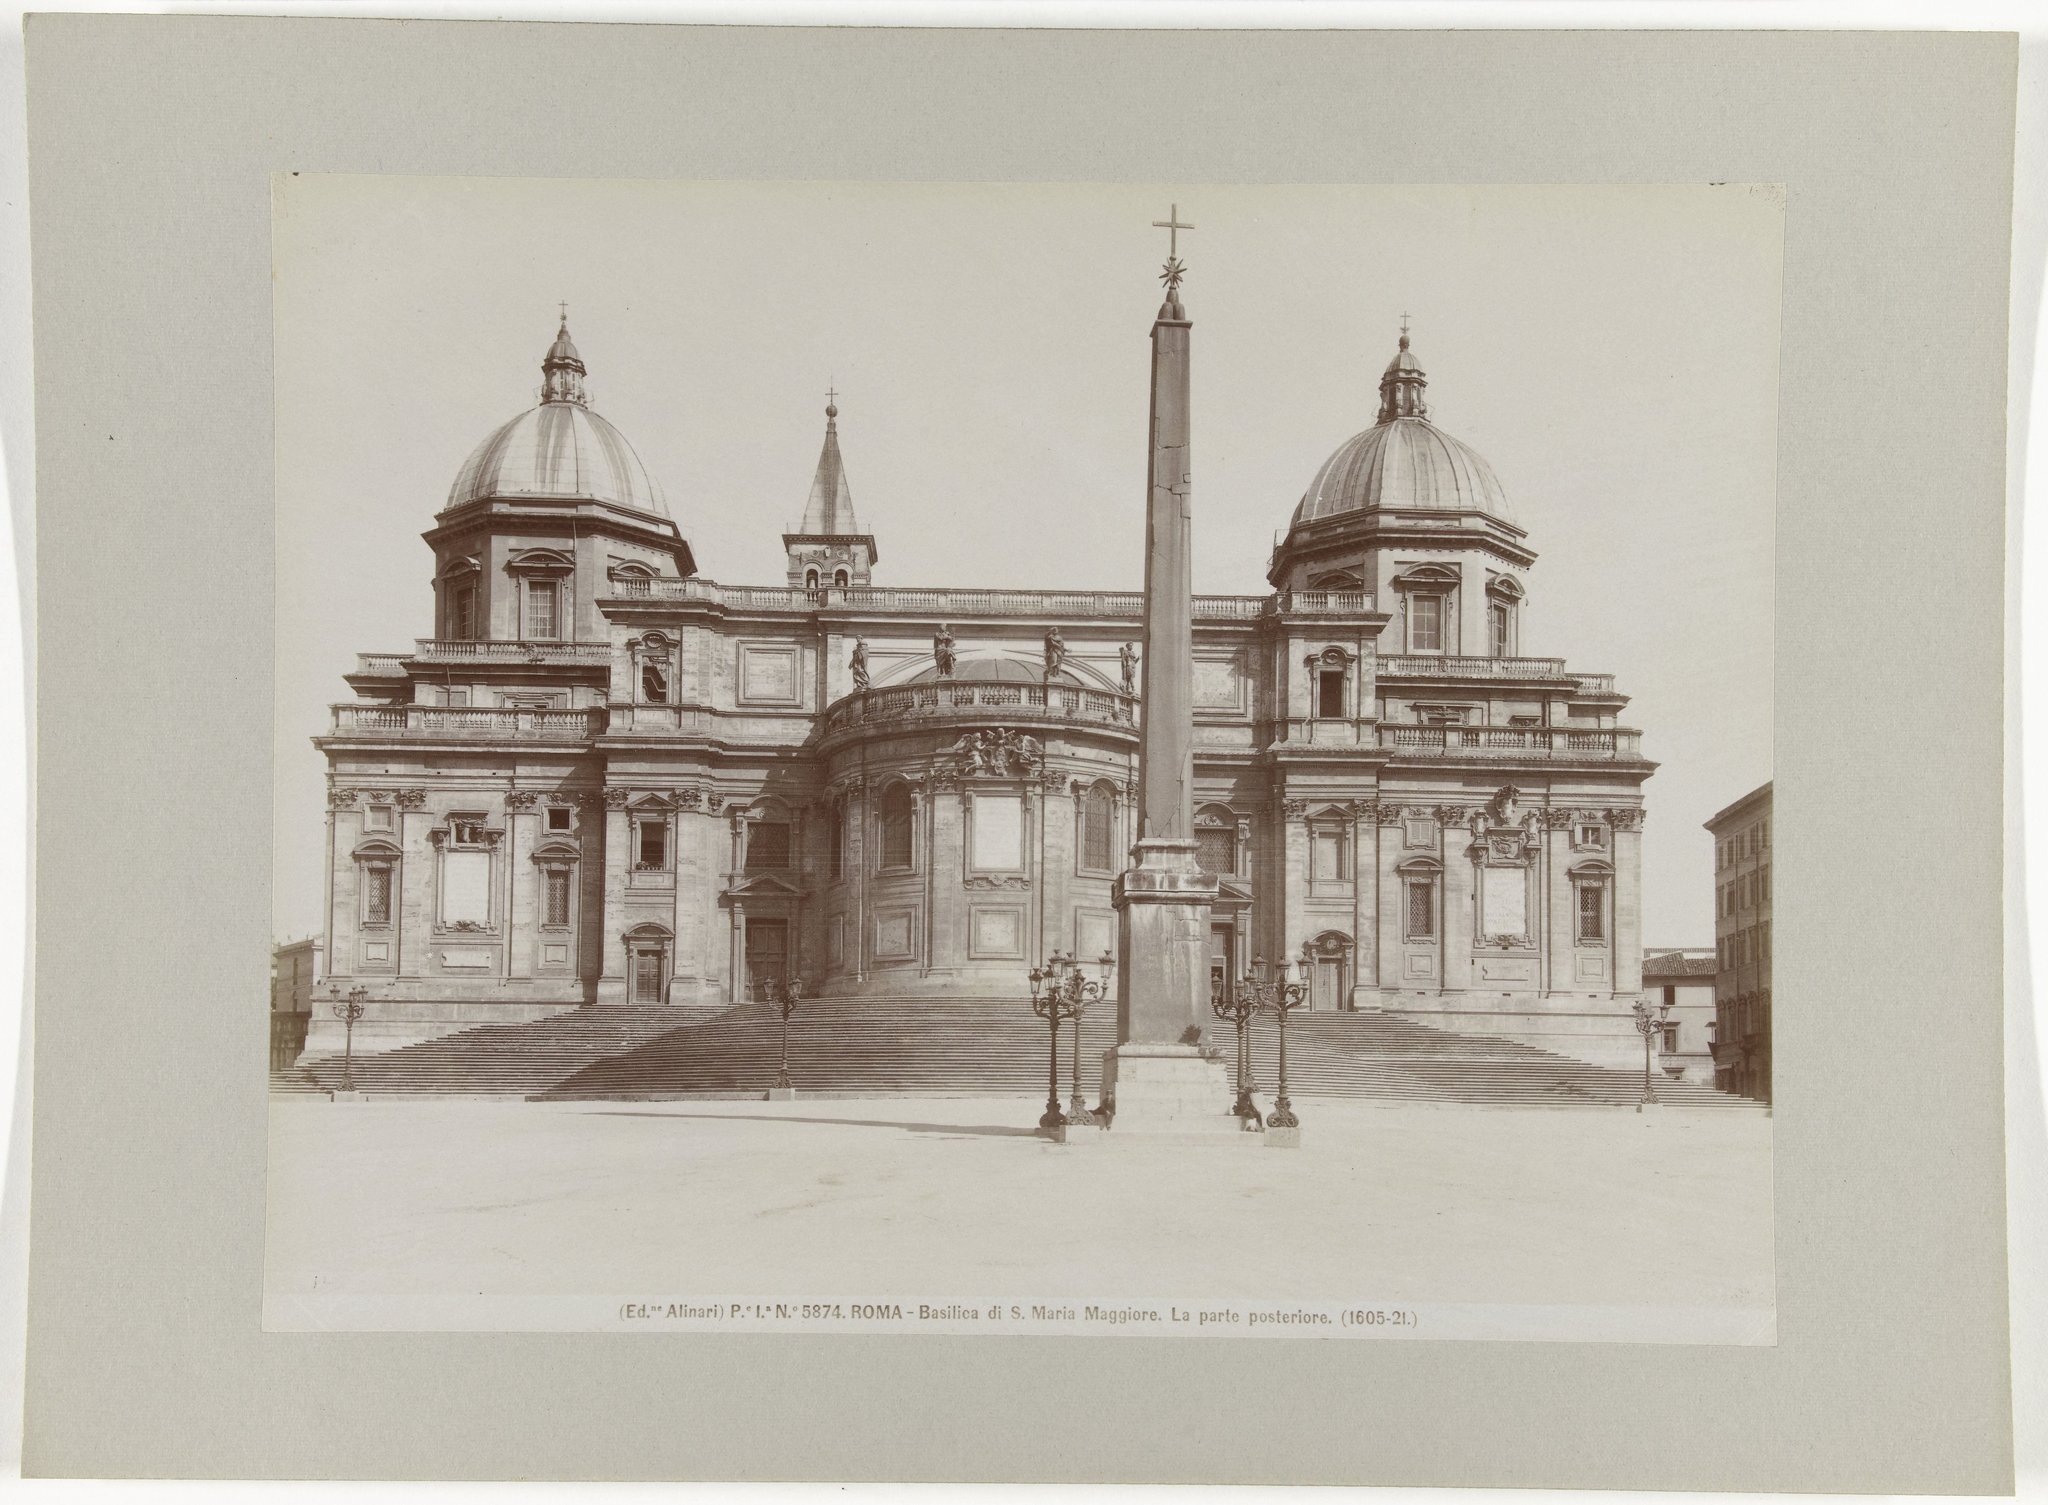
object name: photograph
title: Achtergevel van de Santa Maria Maggiore te Rome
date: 1880-1895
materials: cardboard, paper, photographic support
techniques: albumen print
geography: florence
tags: church (exterior), rome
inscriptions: number: ‘7.’